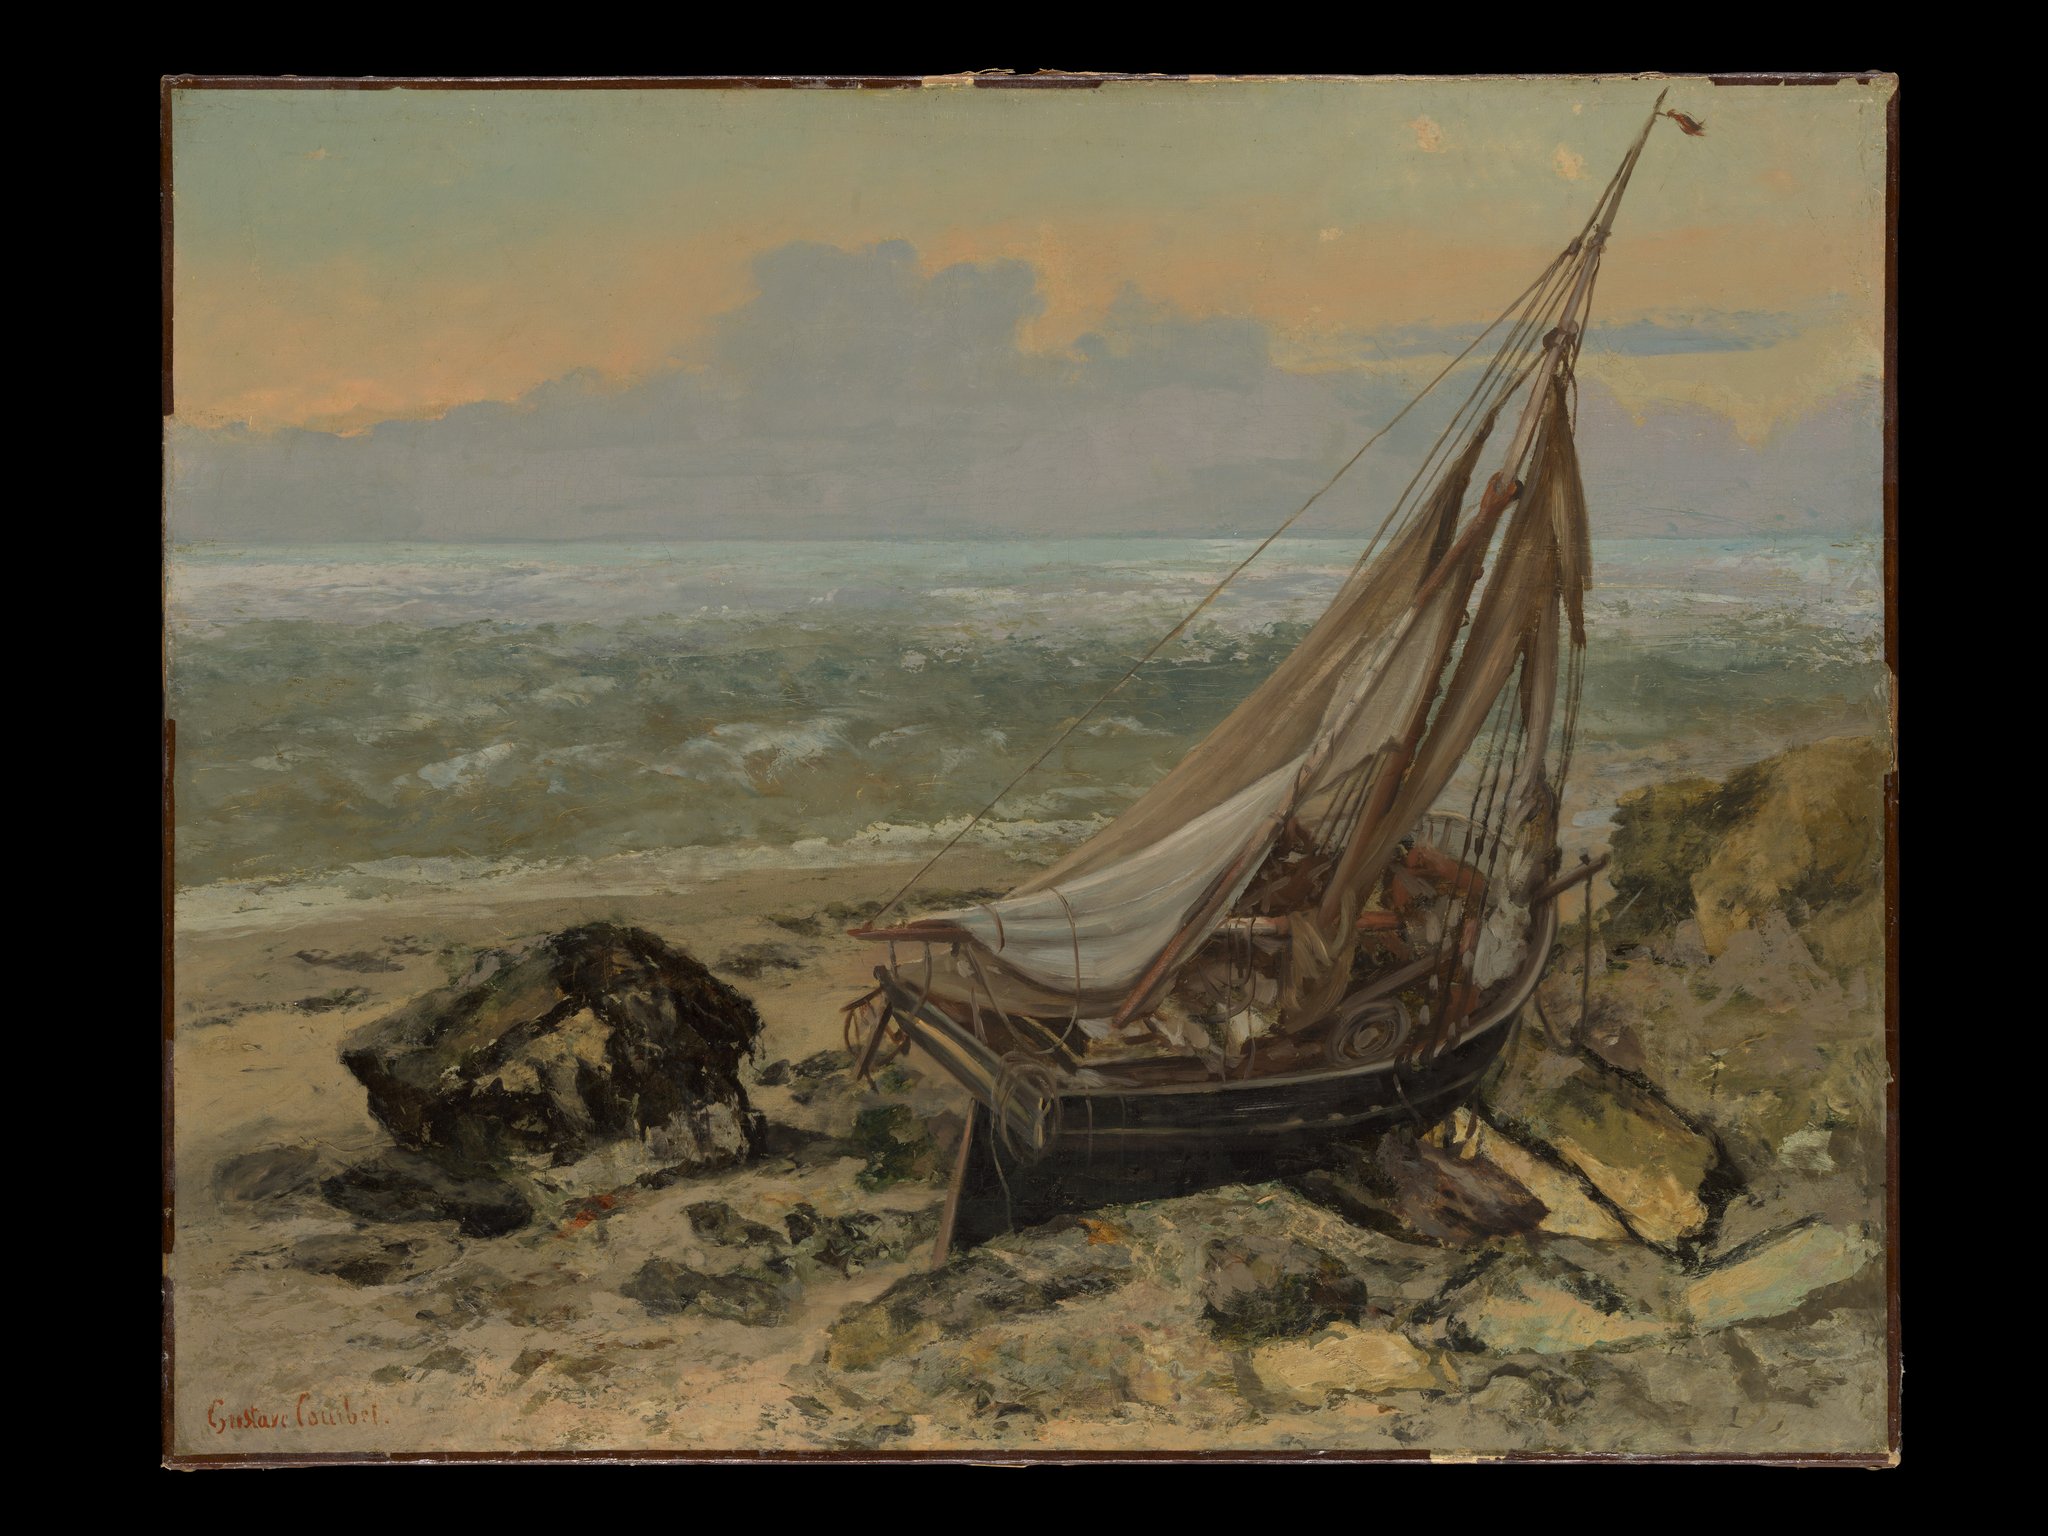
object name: painting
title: The Fishing Boat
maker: gustave courbet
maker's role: artist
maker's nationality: french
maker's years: 1819-1877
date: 1865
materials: canvas, oil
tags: seascapes,boats